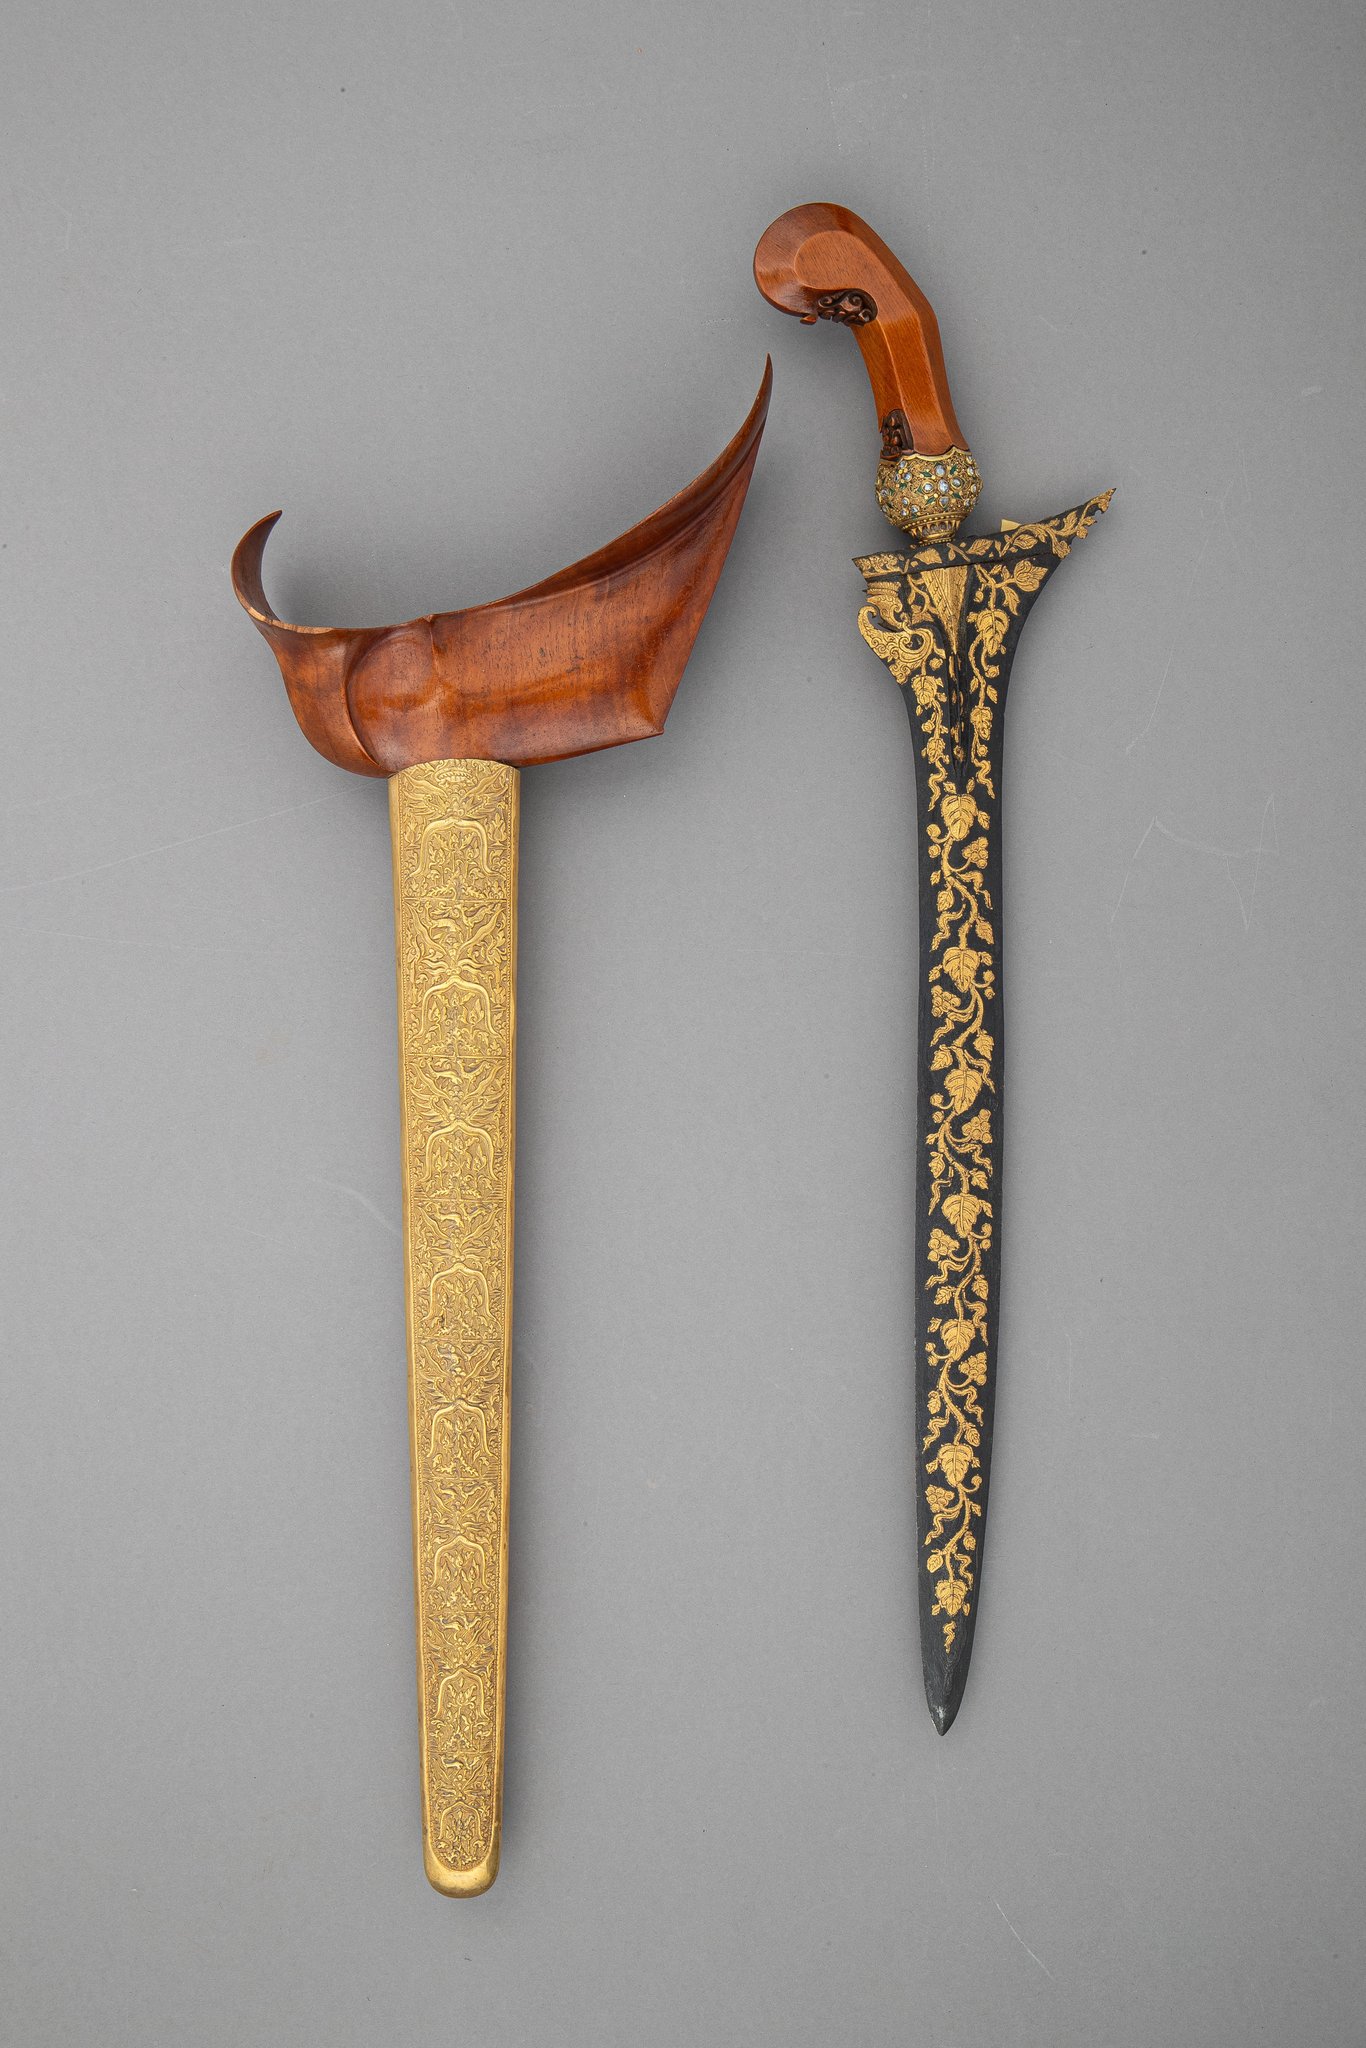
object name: kris with sheath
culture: javanese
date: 1801-1900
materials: diamond, enamel, gold, silver, steel, wood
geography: indonesia